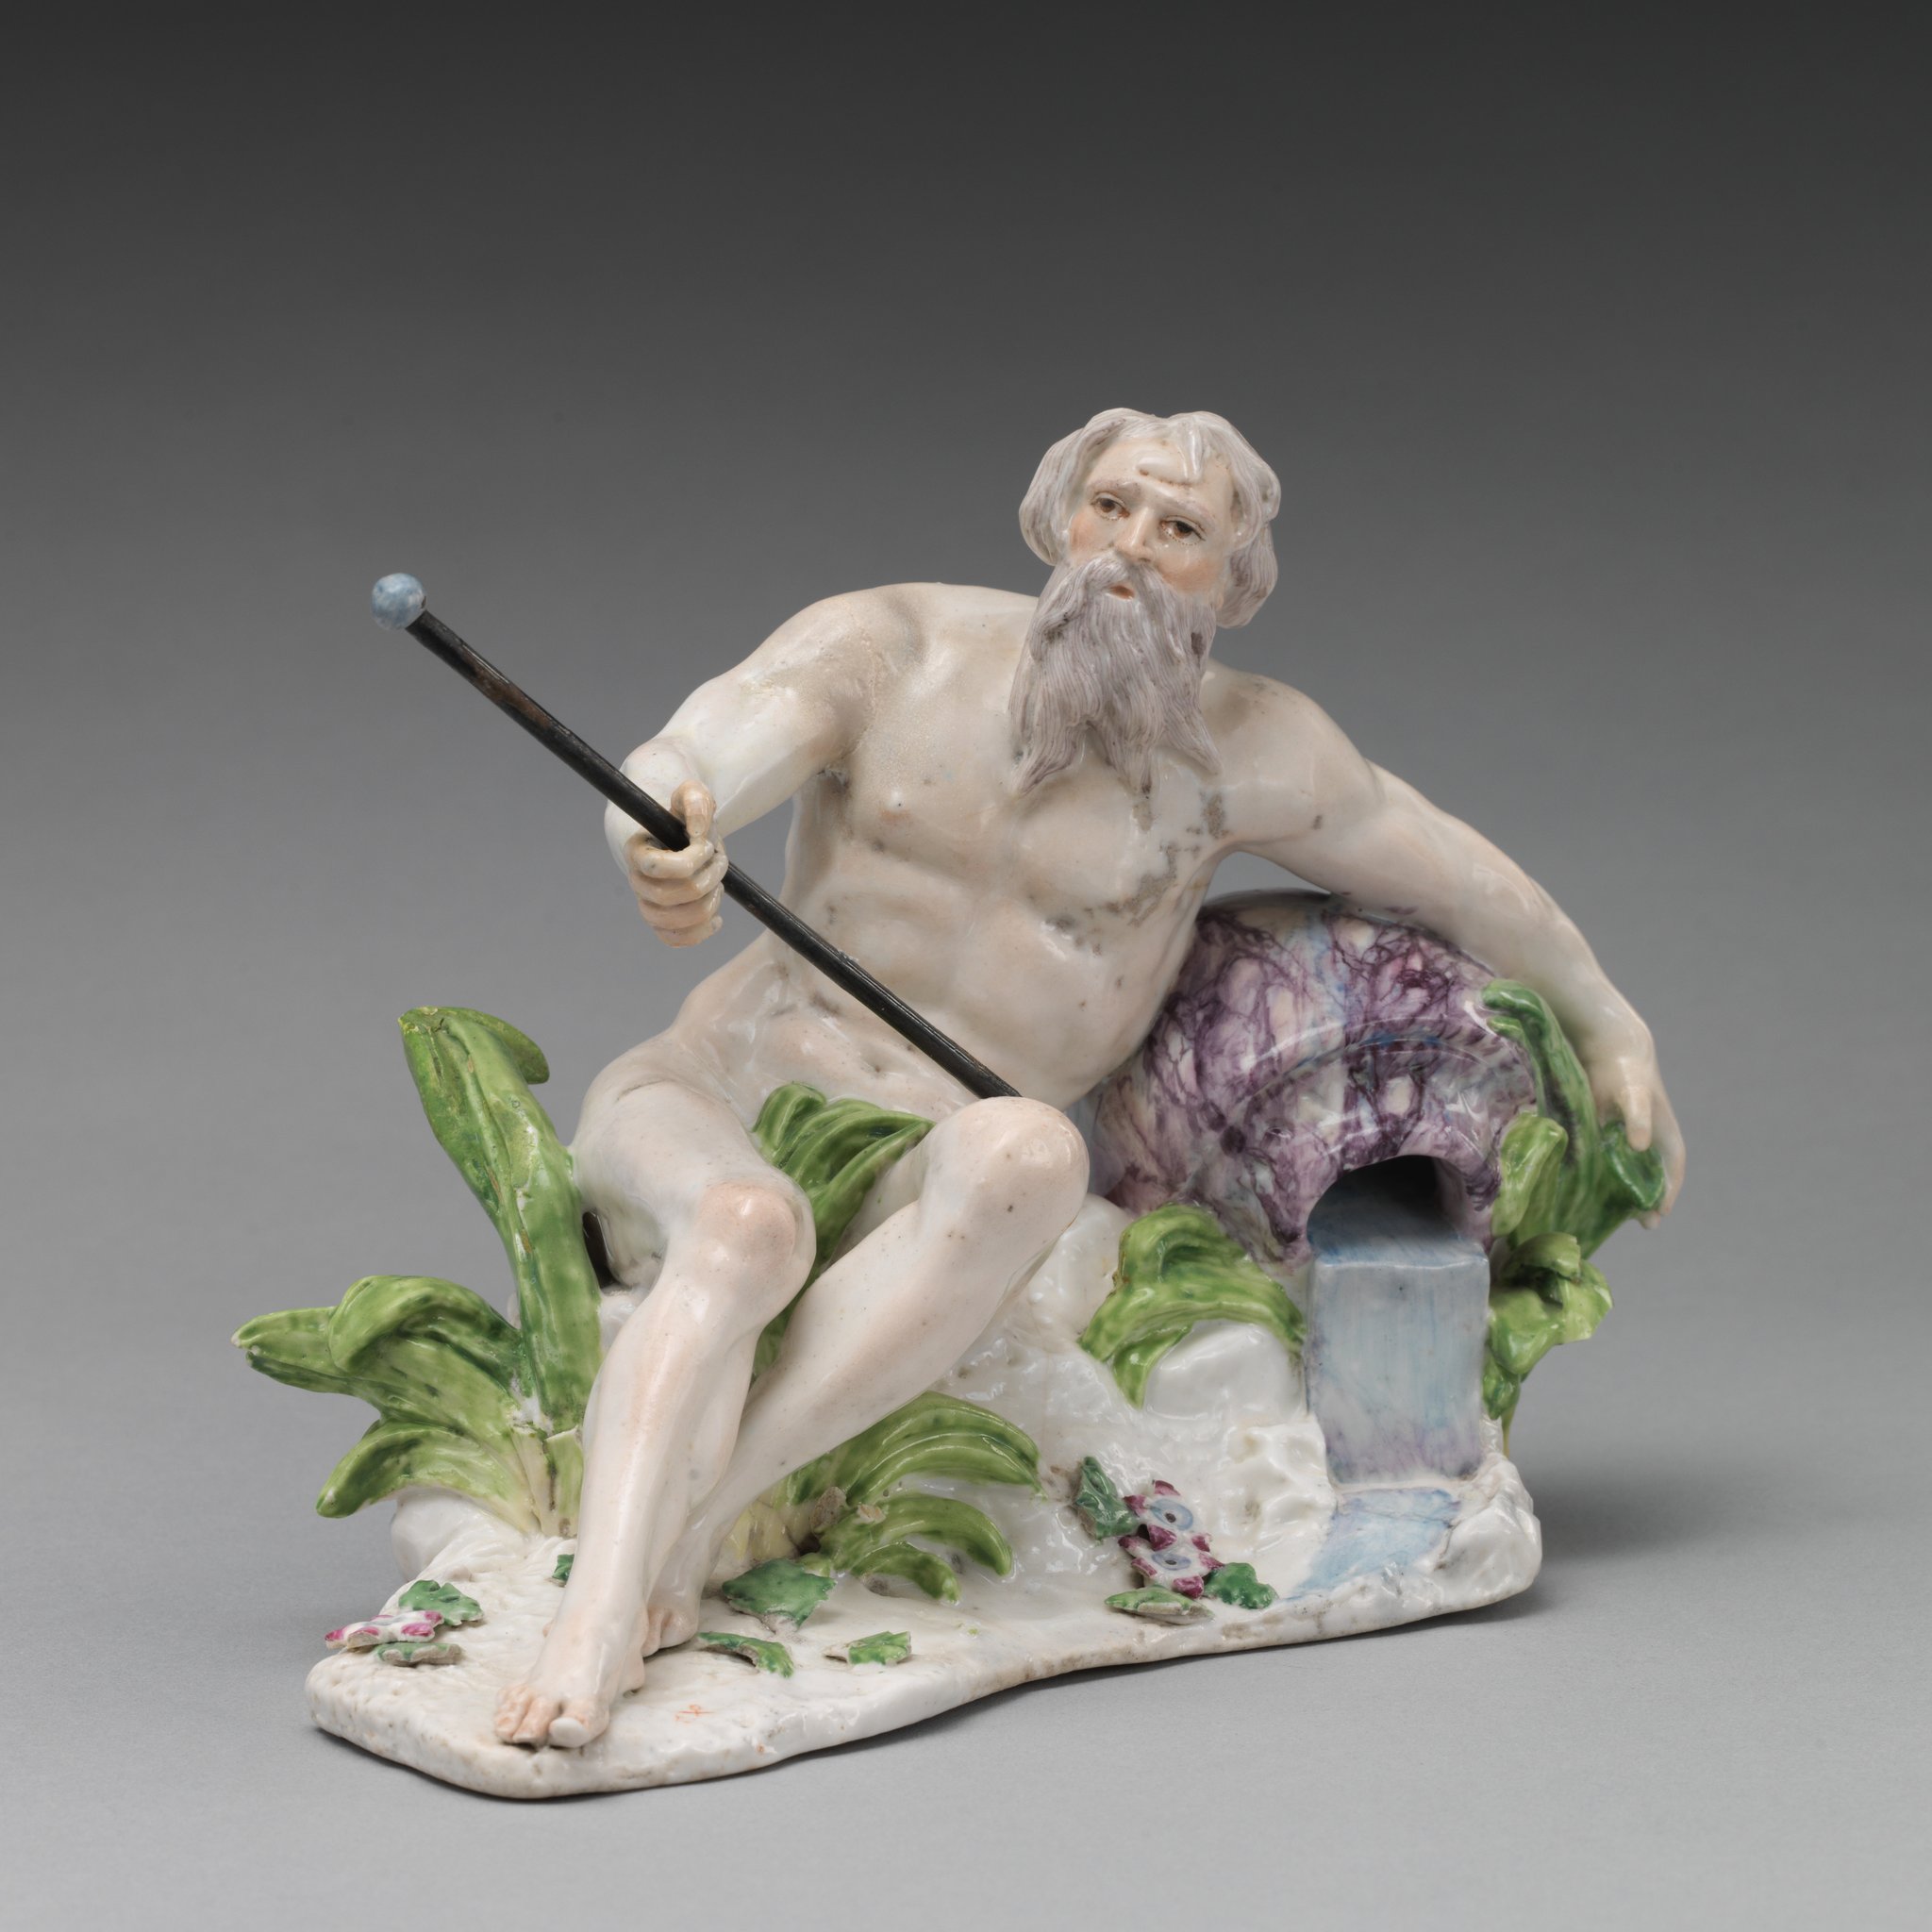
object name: figure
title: River God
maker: chelsea porcelain manufactory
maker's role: factory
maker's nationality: british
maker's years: 1744-1784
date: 1753-1754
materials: soft paste porcelain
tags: men,women